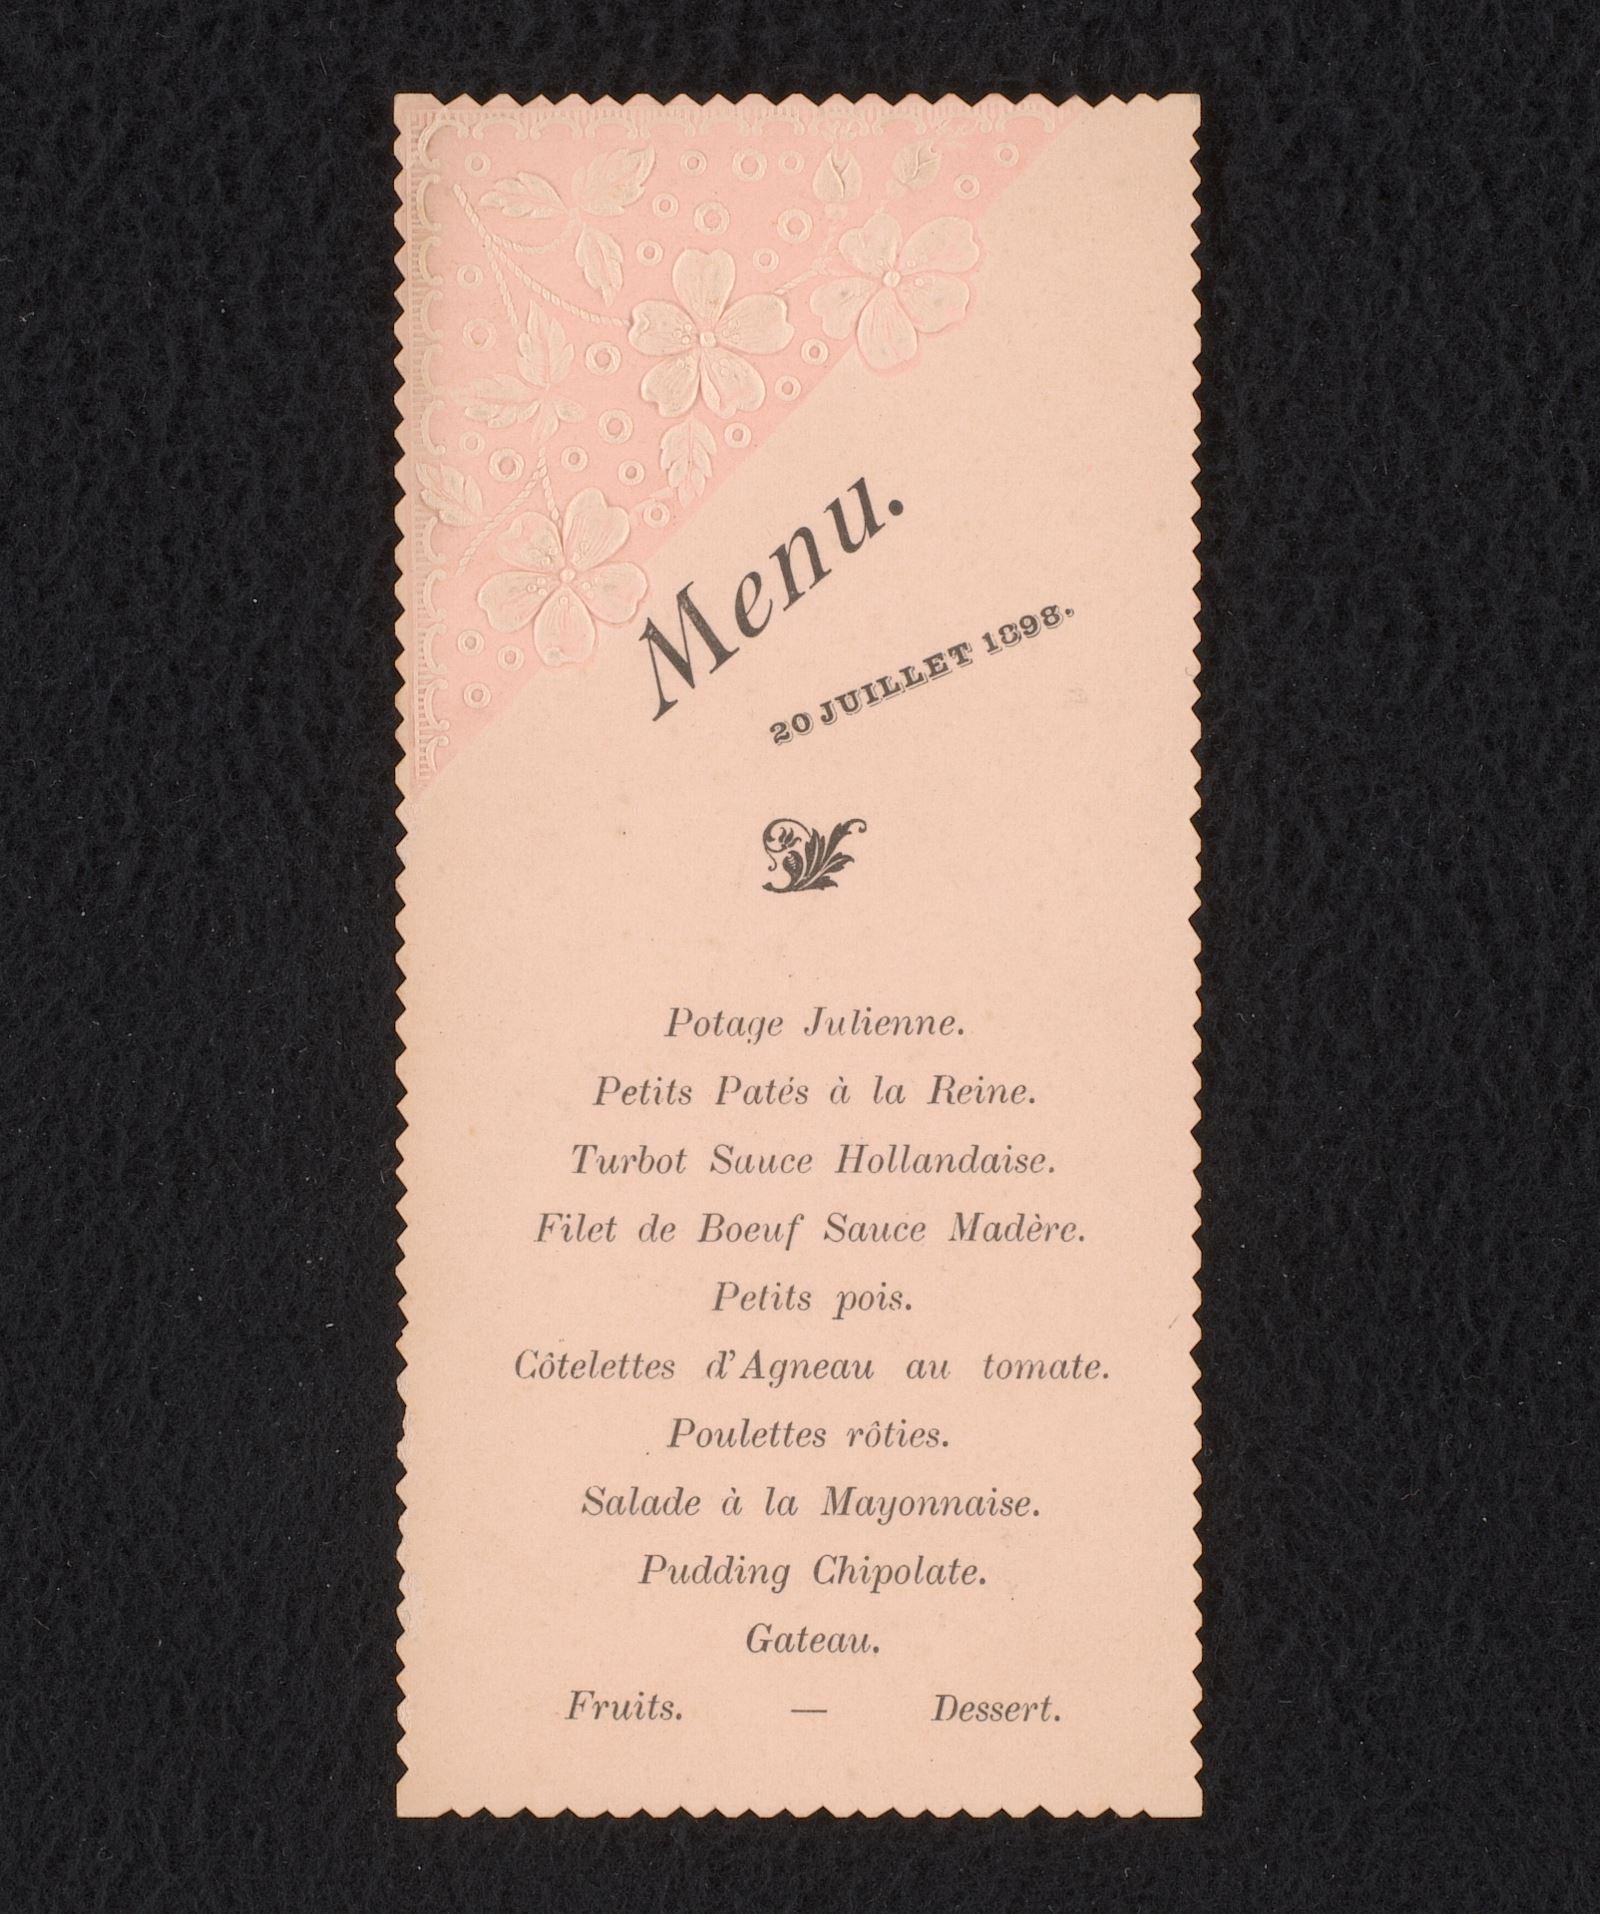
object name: menu, menukaart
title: Menukaart voor een diner op 20 juli 1898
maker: Anonymous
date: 1898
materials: paper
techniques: blind stamped, letterpress printing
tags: flowers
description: Bij gebrek aan gegevens over de vervaardiger is voor de bepaling van de rechten van dit object gebruik gemaakt van de vervaardigingsdatum.